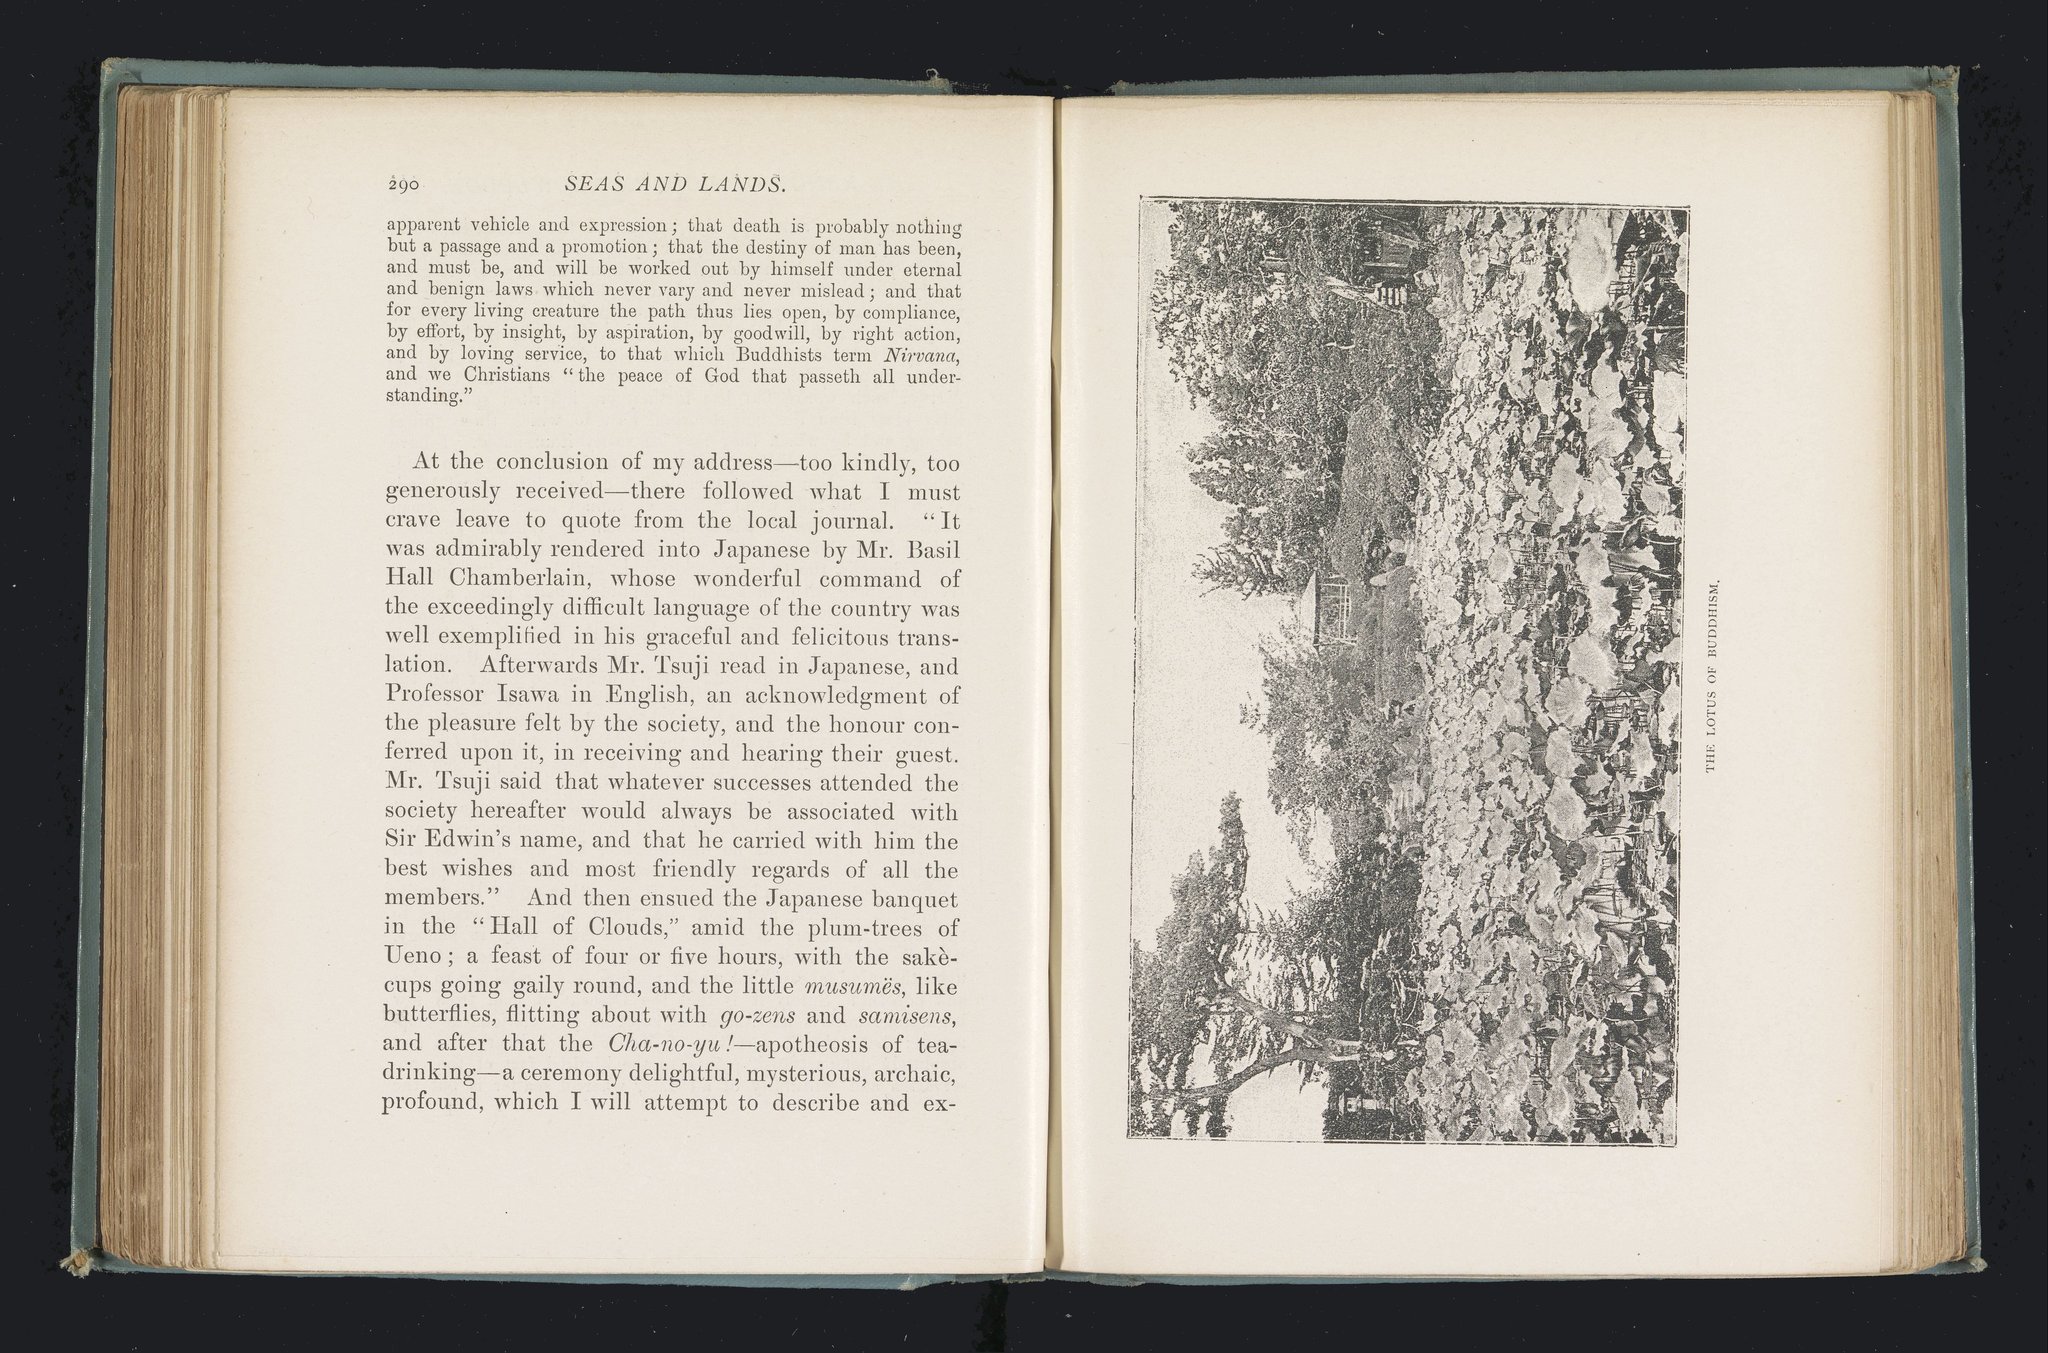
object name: page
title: The lotus of Buddhism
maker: Anonymous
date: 1882-1892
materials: paper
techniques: autotype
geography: japan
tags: flowers: lotus